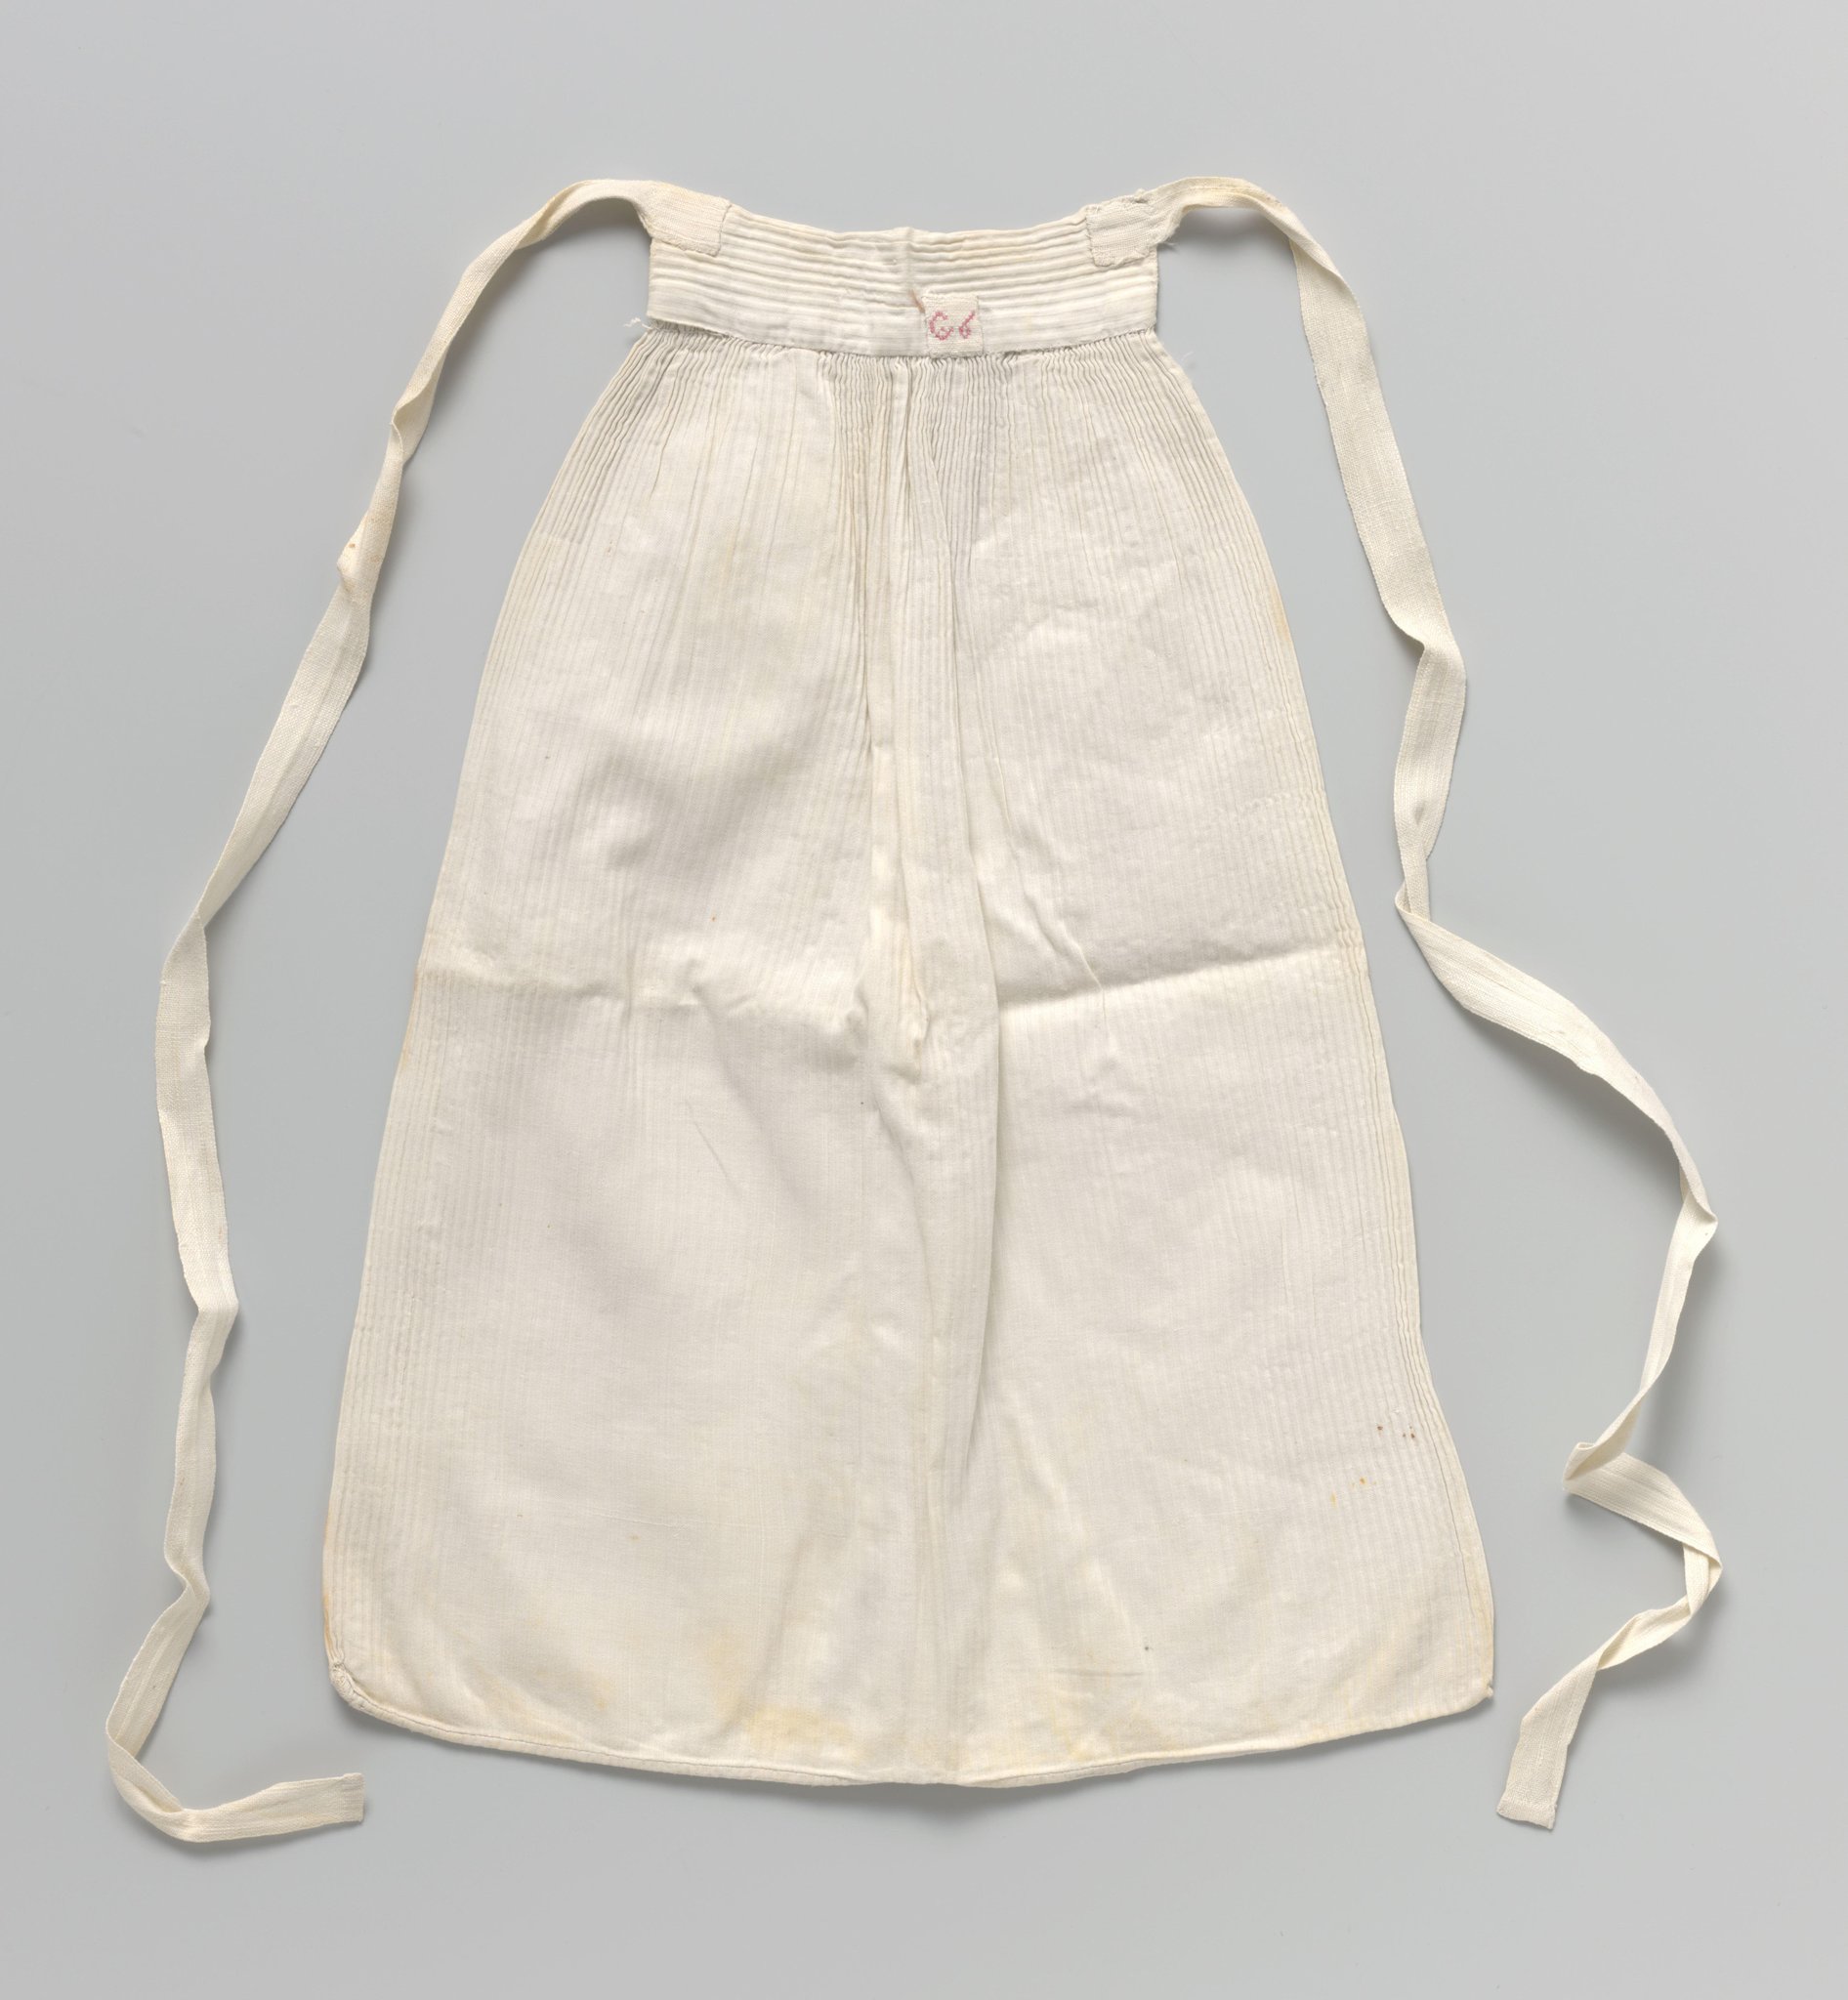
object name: pocket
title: Rokzak van wit katoen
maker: Anonymous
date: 1850-1920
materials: cotton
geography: europe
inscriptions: initials: ‘G6’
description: Het textiel heeft een ingeweven patroon van verticale lijnen.